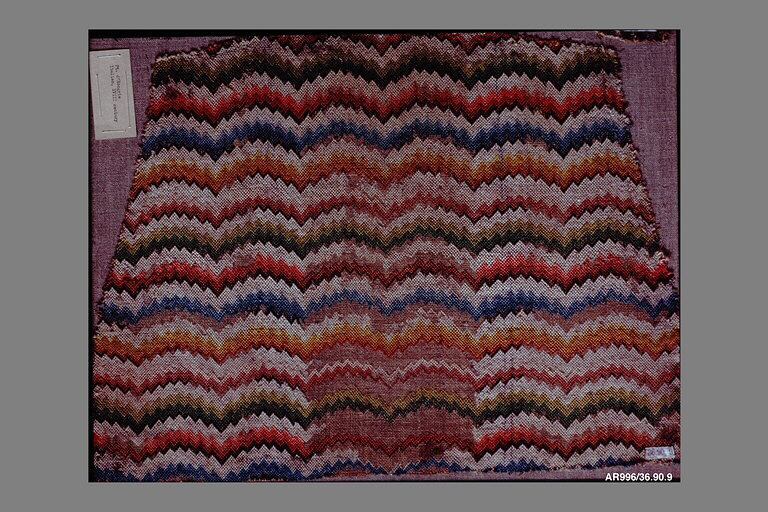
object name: piece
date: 1601-1800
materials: canvas, silk